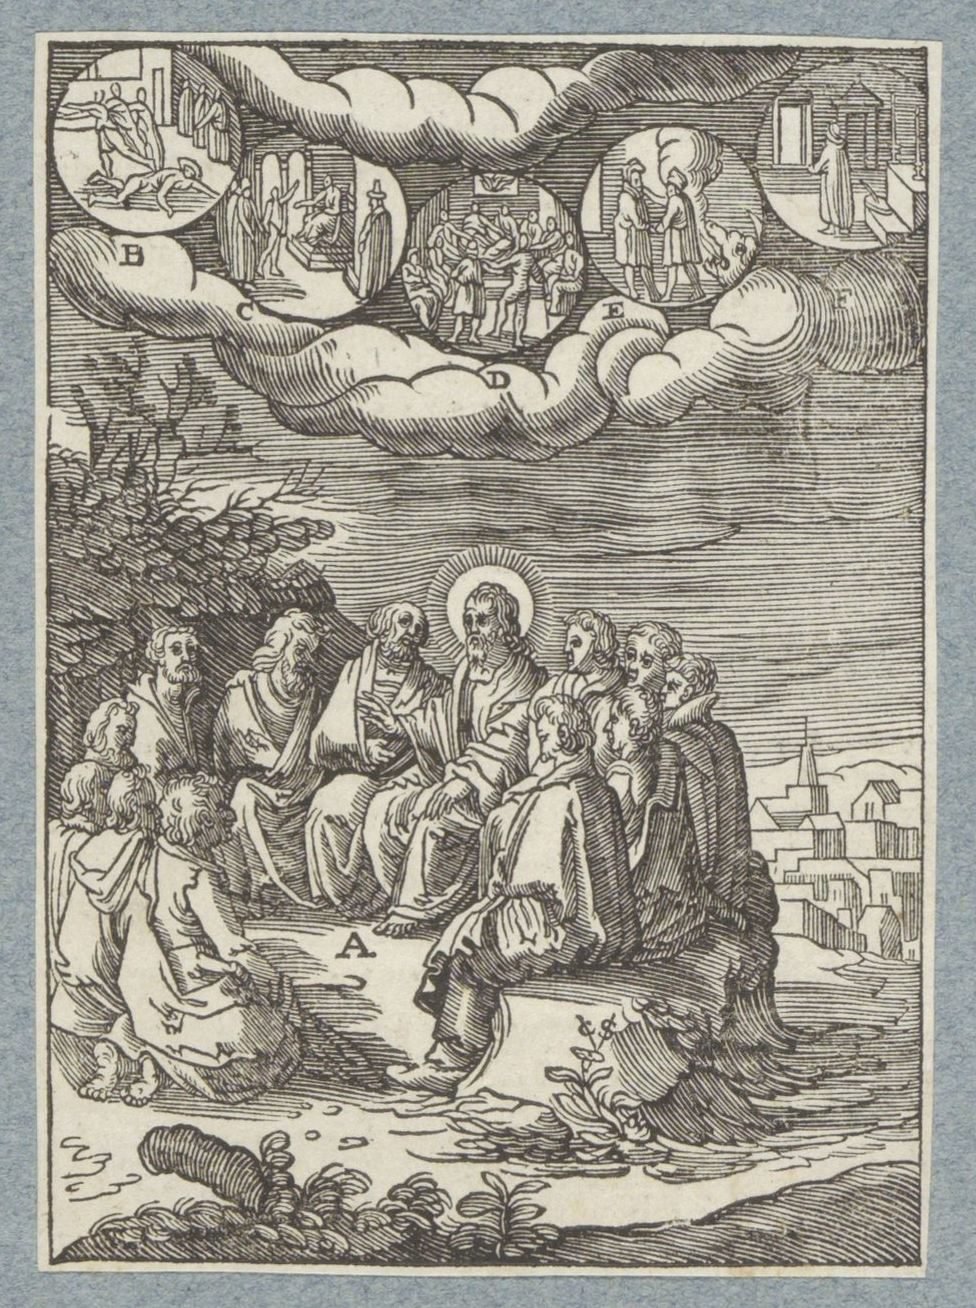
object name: print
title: Bergrede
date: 1629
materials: paper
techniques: letterpress printing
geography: amsterdam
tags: christ's sermon on the mount (matthew 5-7)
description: De prent is afkomstig uit een van de uitgaven van P.J. Paets uit Amsterdam. De prent wordt voor het eerst gebruikt in: Der Zielen Lust-hof. Leuven, I.Jacbosz voor P.J. Paets [= Amsterdam, P.J. Paets], 1629. De voorstelling is gekopieerd naar een prent van Antonie II Wierix voor: Nadal, Jerónimo. Evangelicae Historiae Imagines. Antwerpen, M. Nutius, 1593.